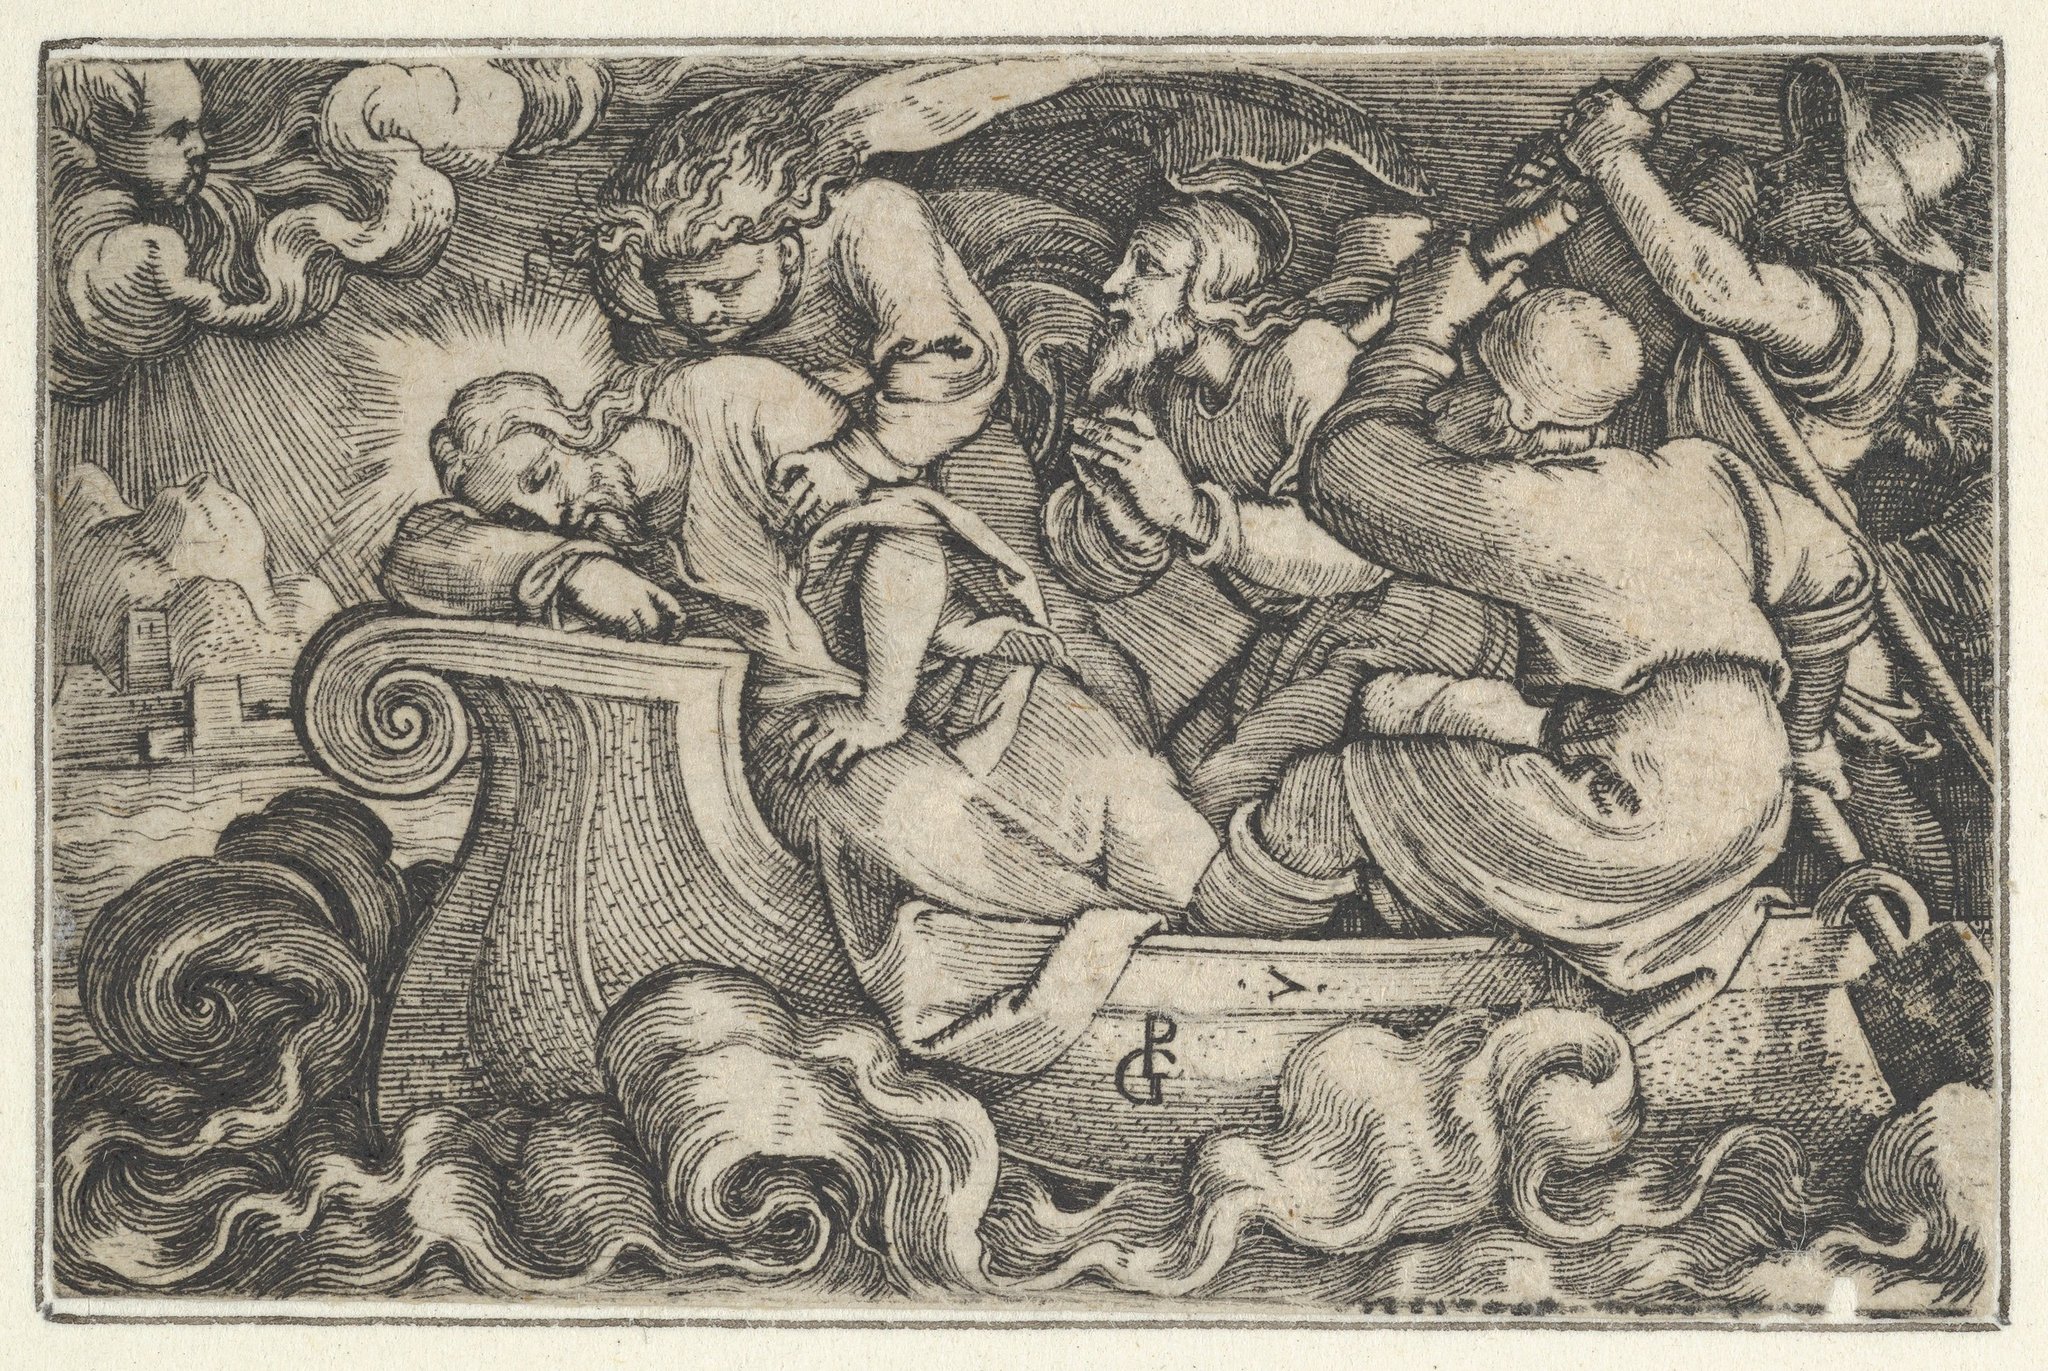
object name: print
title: Christ Sleeping During the Storm on Lake Tiberias, from "The Story of Christ"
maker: georg pencz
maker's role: artist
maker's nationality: german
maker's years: 1500-1550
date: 1534-1535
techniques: engraving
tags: sleeping,men,lakes,storms,christ